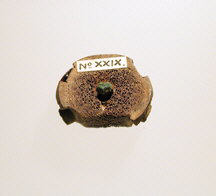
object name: fibula, fragment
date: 700-501 BCE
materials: amber, bone, bronze, ivory